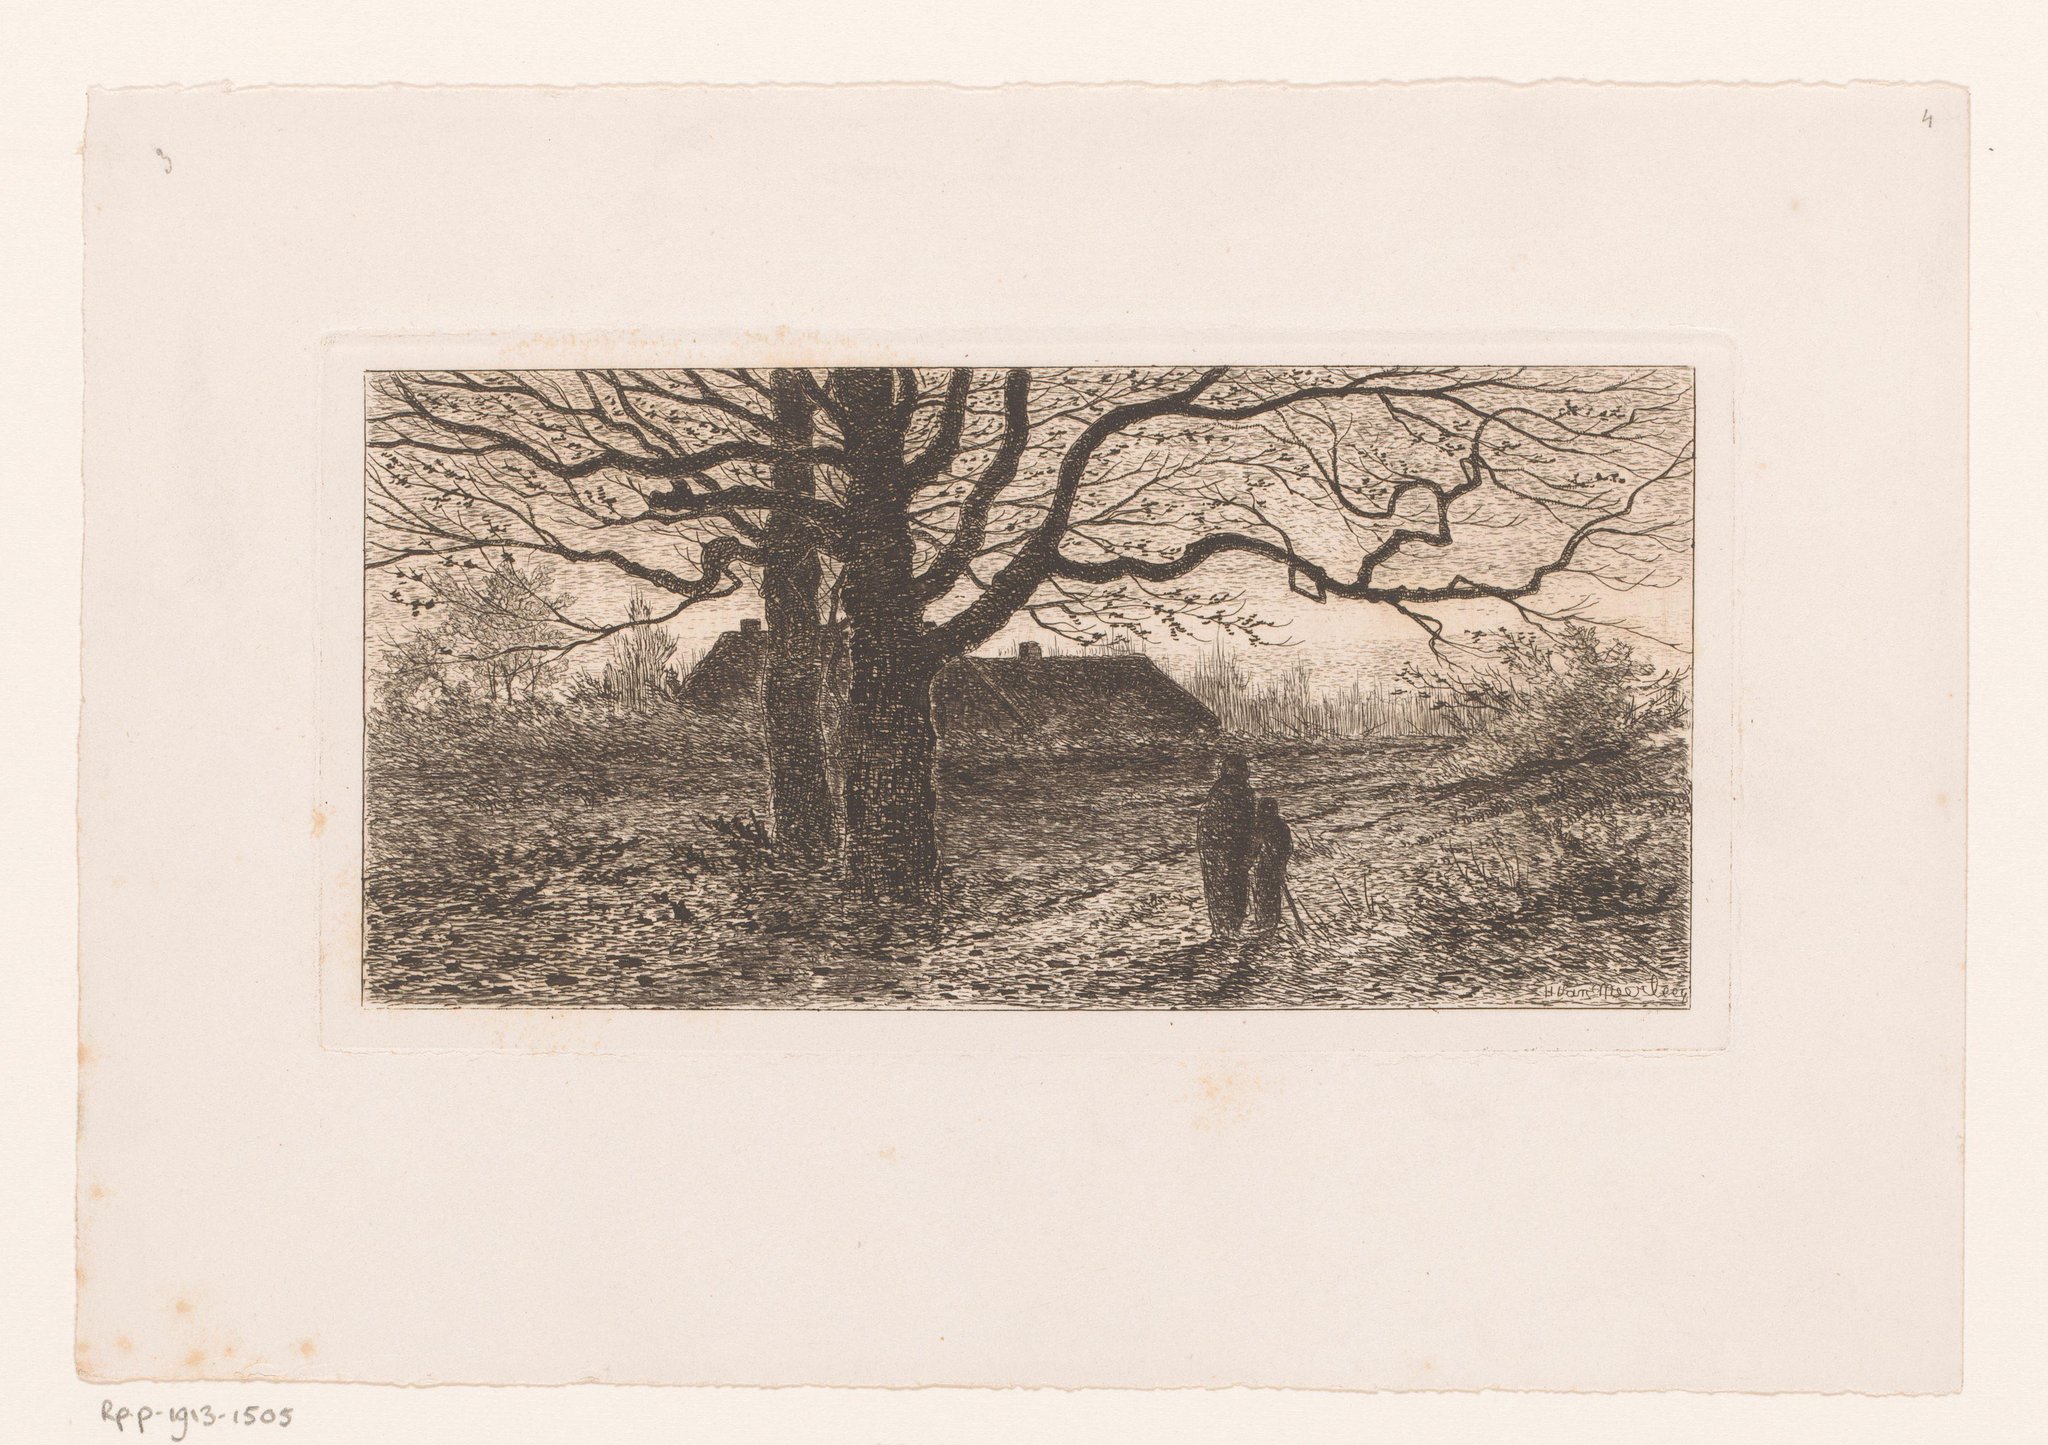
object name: print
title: Landschap met twee figuren bij een boerderij en twee grote bomen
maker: h. van meerbeeck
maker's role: print maker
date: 1850-1913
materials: paper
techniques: etching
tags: trees, farm or solitary house in landscape (+ city(-scape) with figures, staffage)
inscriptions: collector's mark: Lugt 2228